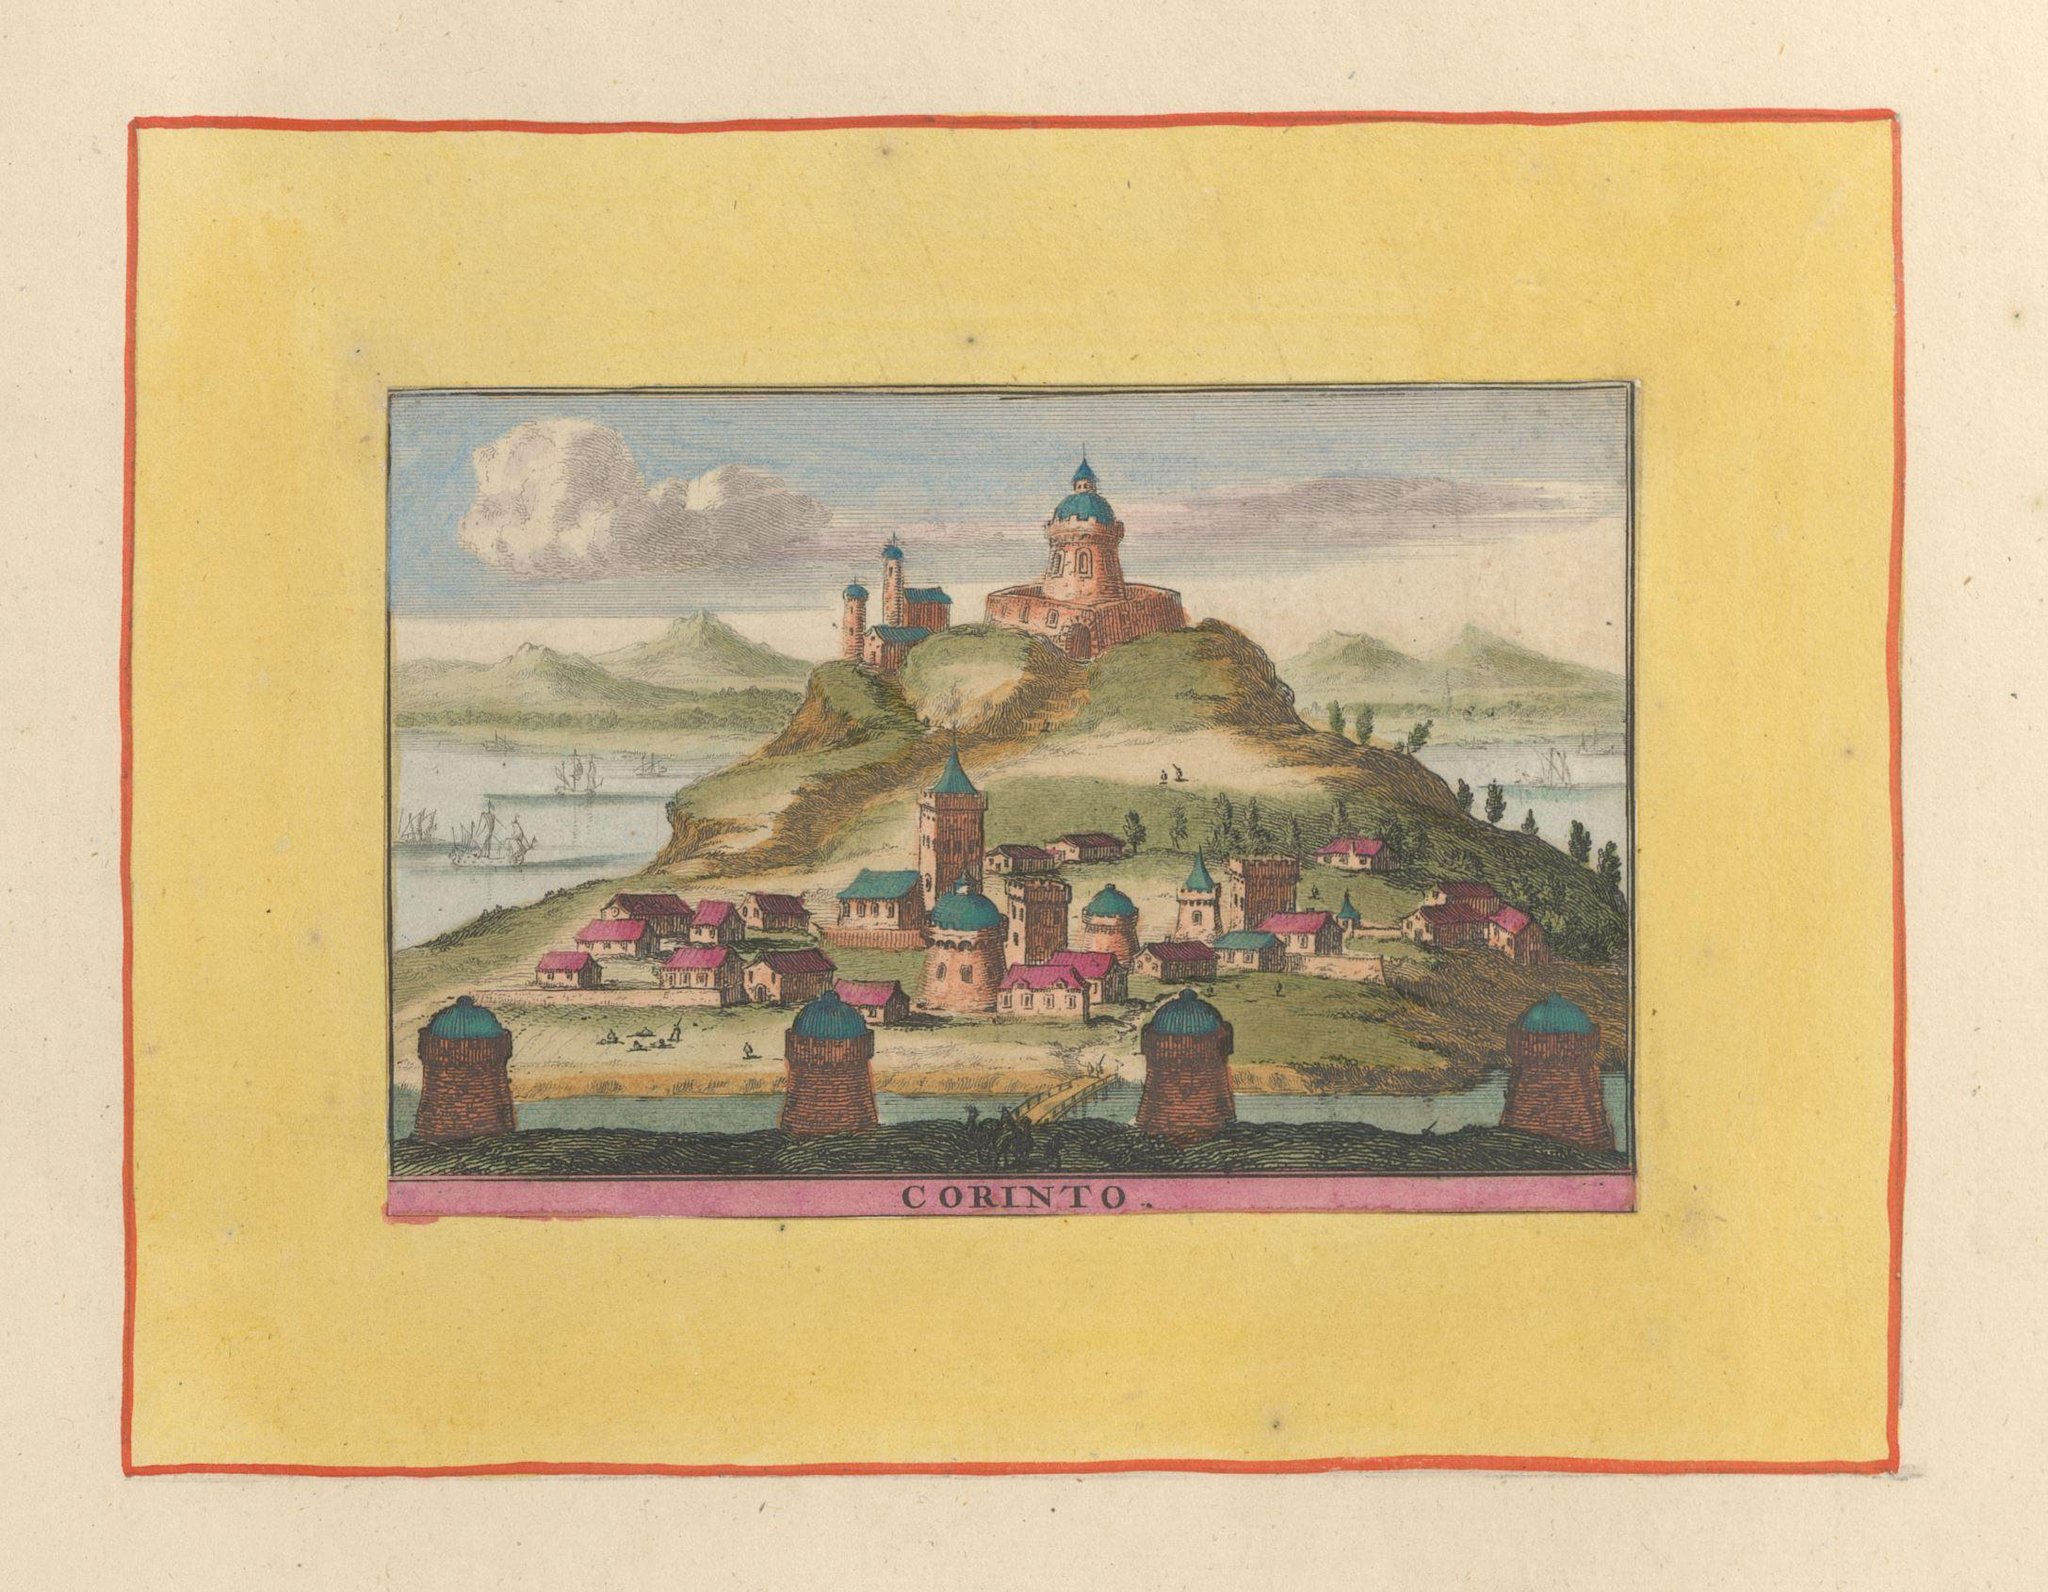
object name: album leaf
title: Griekse vestingsteden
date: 1679-1702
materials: paper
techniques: colour, etching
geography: amsterdam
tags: city-view, and landscape with man-made constructions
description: Prent maakt deel uit van een set van 16 prenten met voorstellingen van Griekse vestingsteden, oorspronkelijk gedrukt op één blad, die gebruikt konden worden als sieraad rond een kaart.